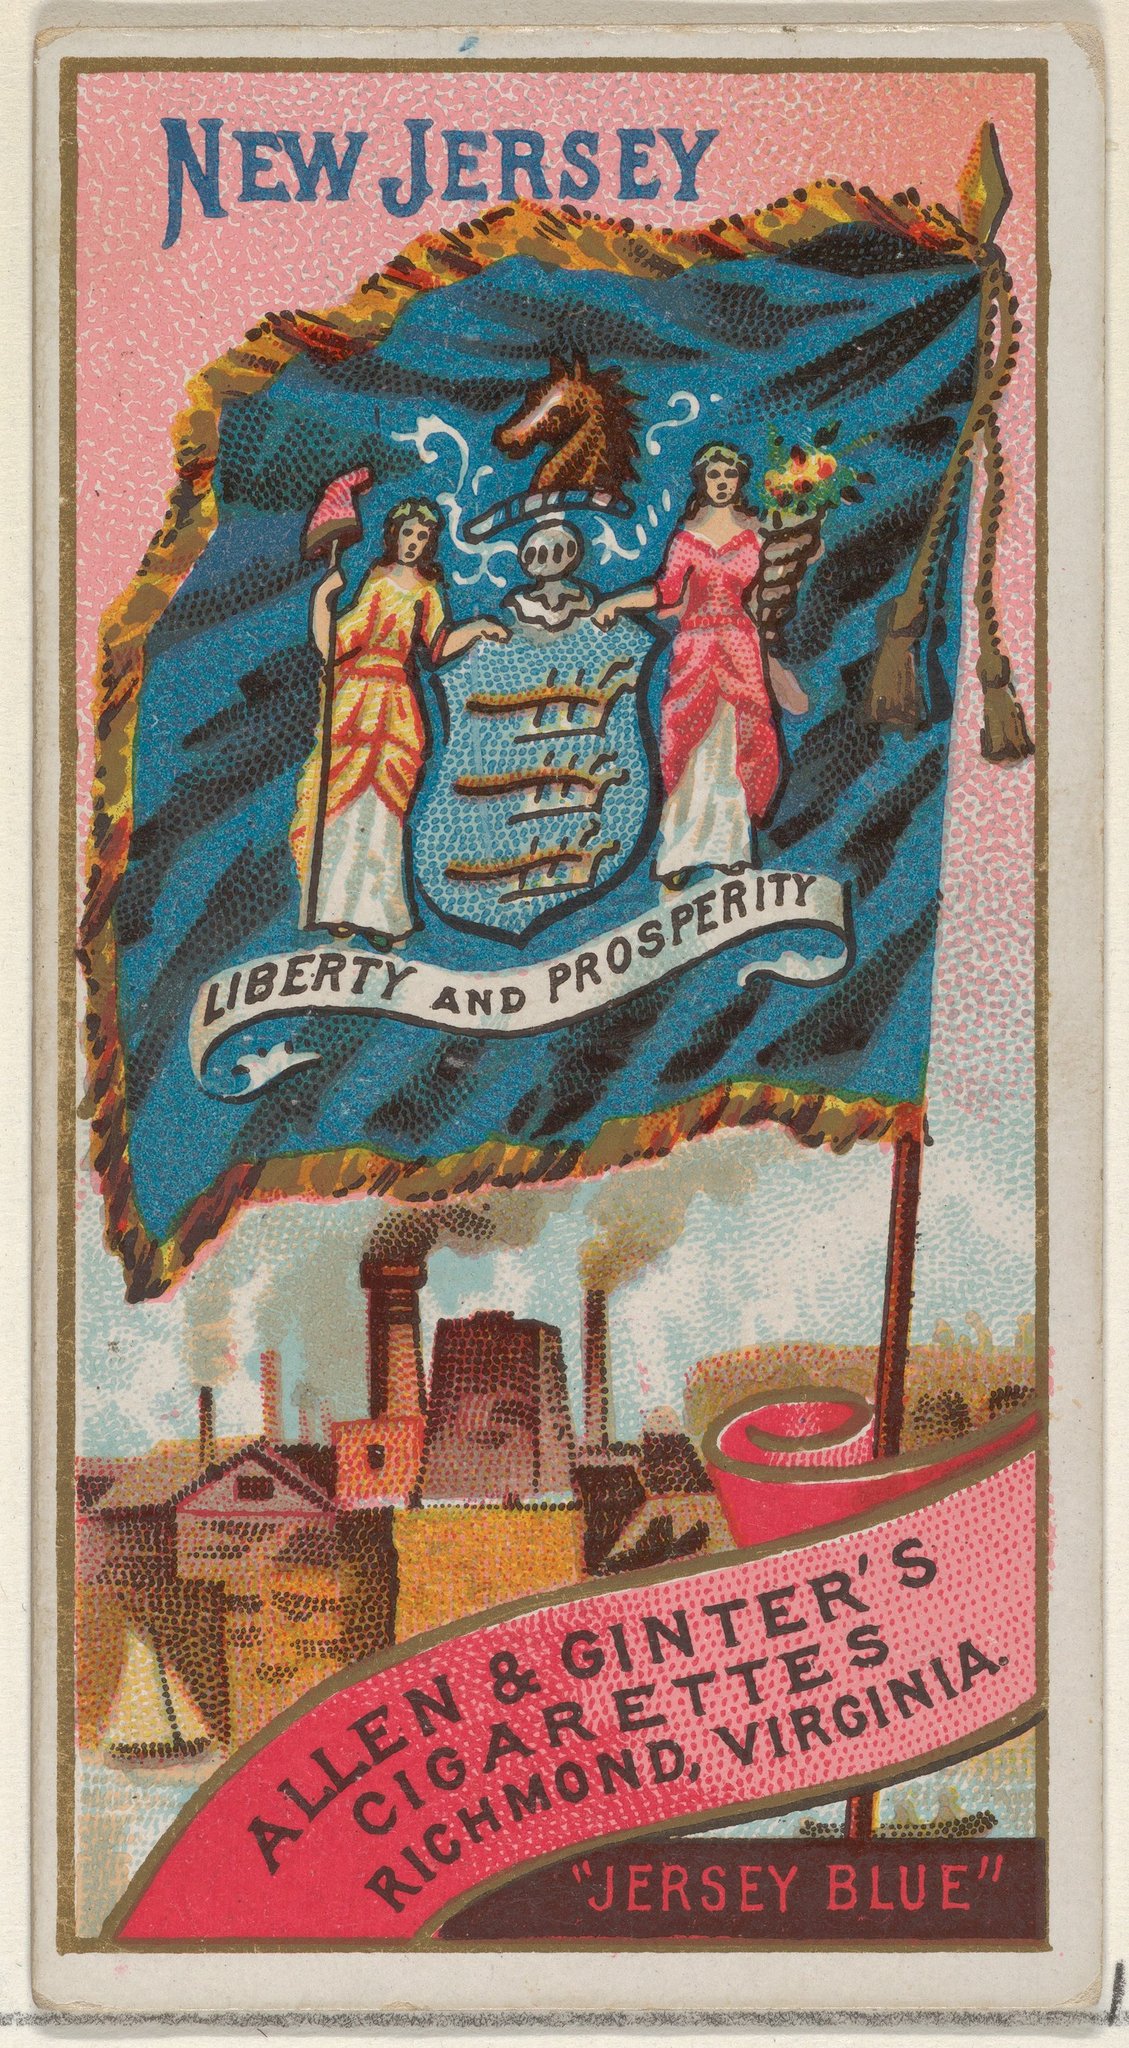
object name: print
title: New Jersey, from Flags of the States and Territories (N11) for Allen & Ginter Cigarettes Brands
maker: allen & ginter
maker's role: publisher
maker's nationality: american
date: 1888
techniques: color lithograph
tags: flags